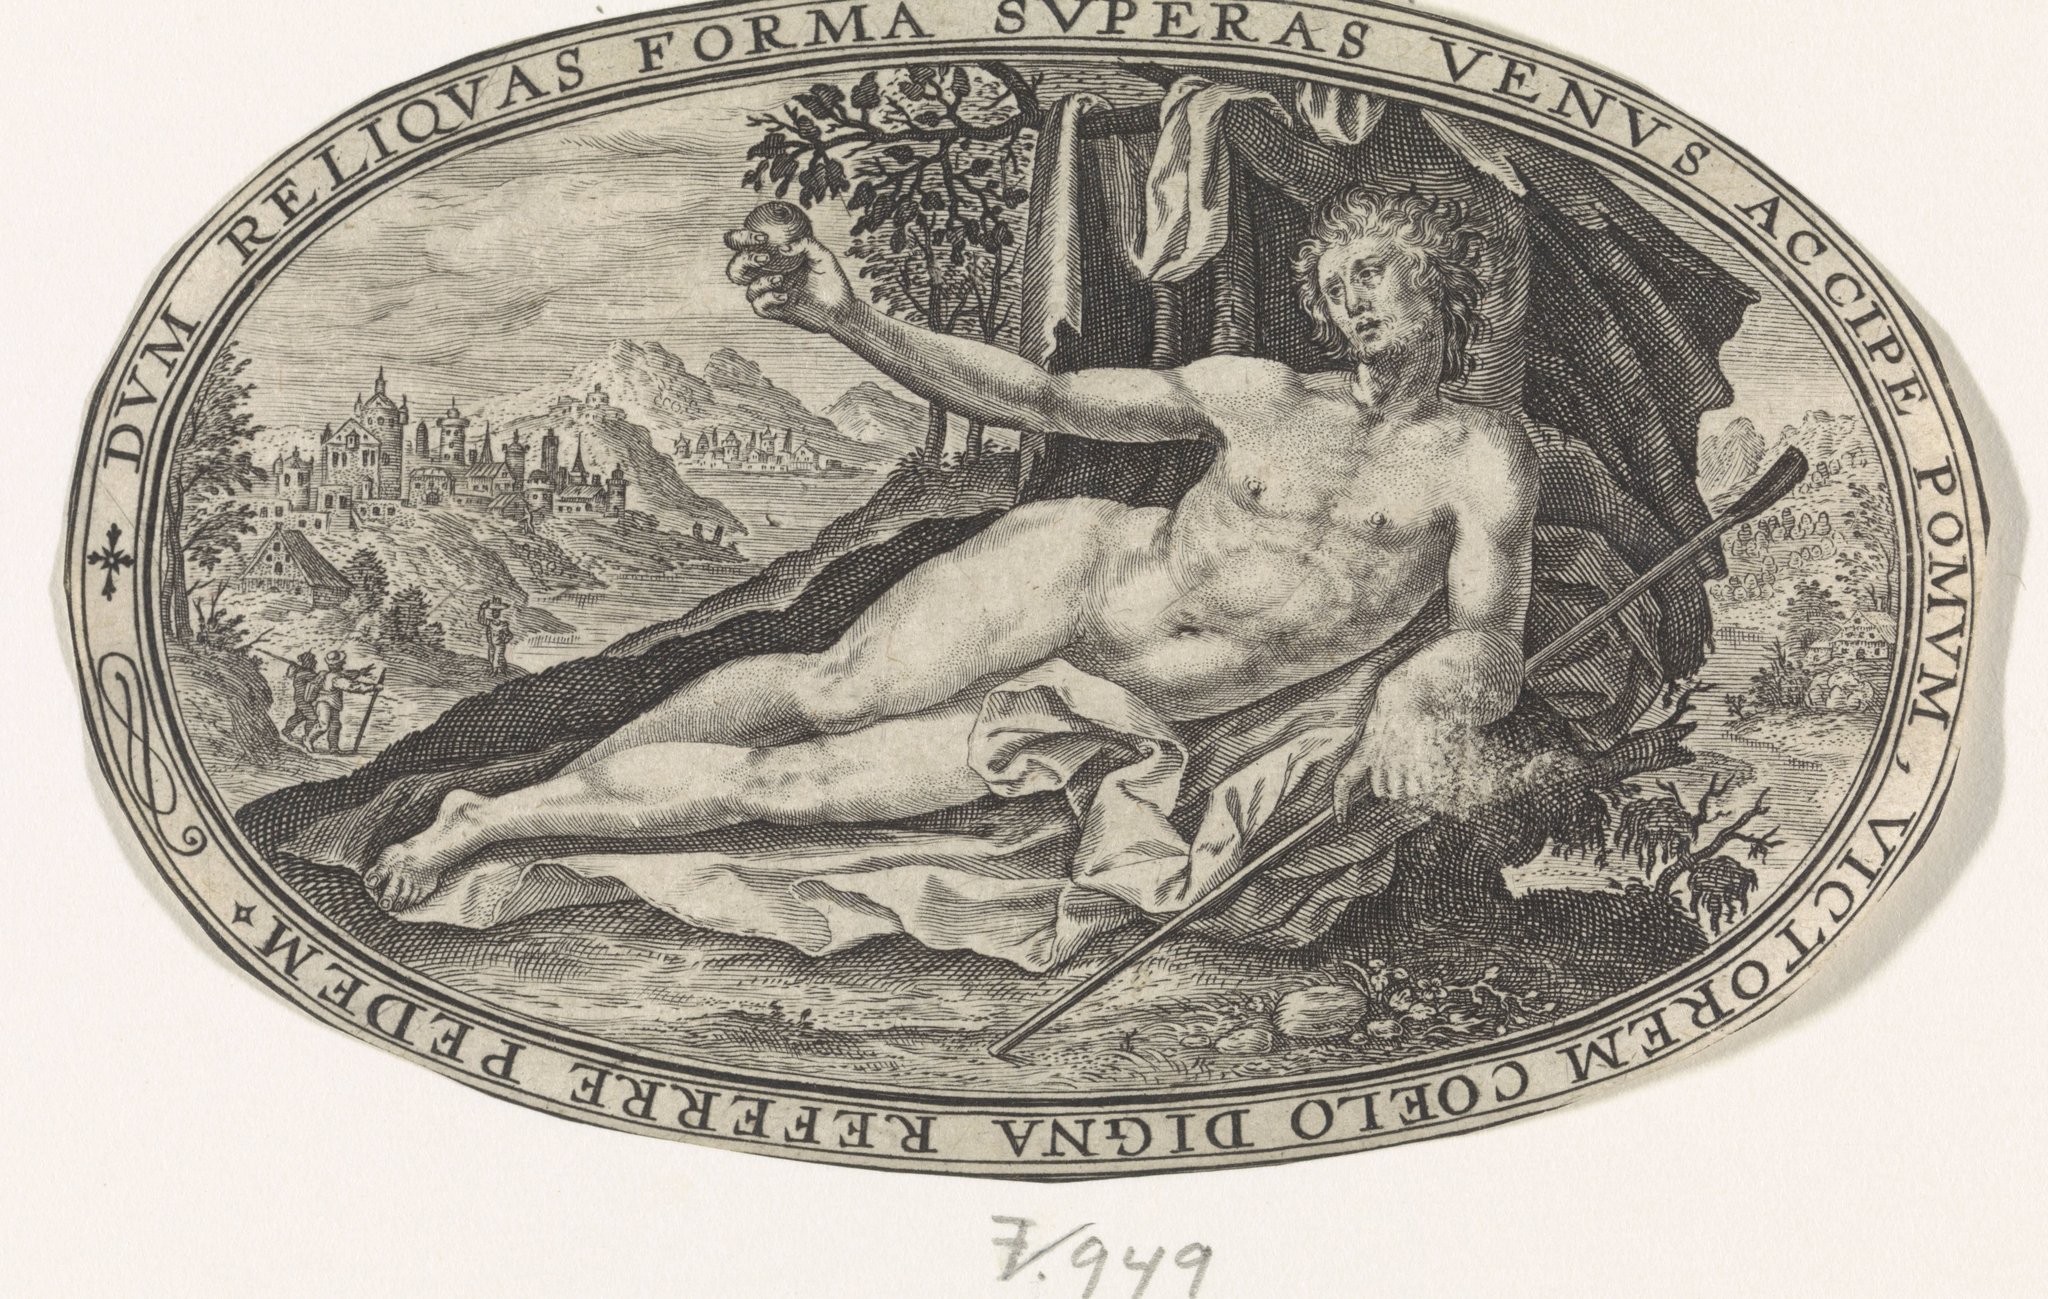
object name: print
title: Paris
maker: crispijn van de passe (i)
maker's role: draughtsman, print maker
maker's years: 1564-1637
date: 1592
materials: paper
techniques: engraving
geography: cologne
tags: paris and the golden apple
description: Landschap met Paris met zijn herdersstaf en de gouden appel van Eris. In de omlijsting een randschrift in het Latijn dat verwijst naar de rol die Paris speelde in het Oordeel van Paris. Hij moest de drie mooiste godinnen van Olympus beoordelen op hun schoonheid en kende de appel uiteindelijk toe aan Venus. Prent uit een serie van zes met Goden en Godinnen.